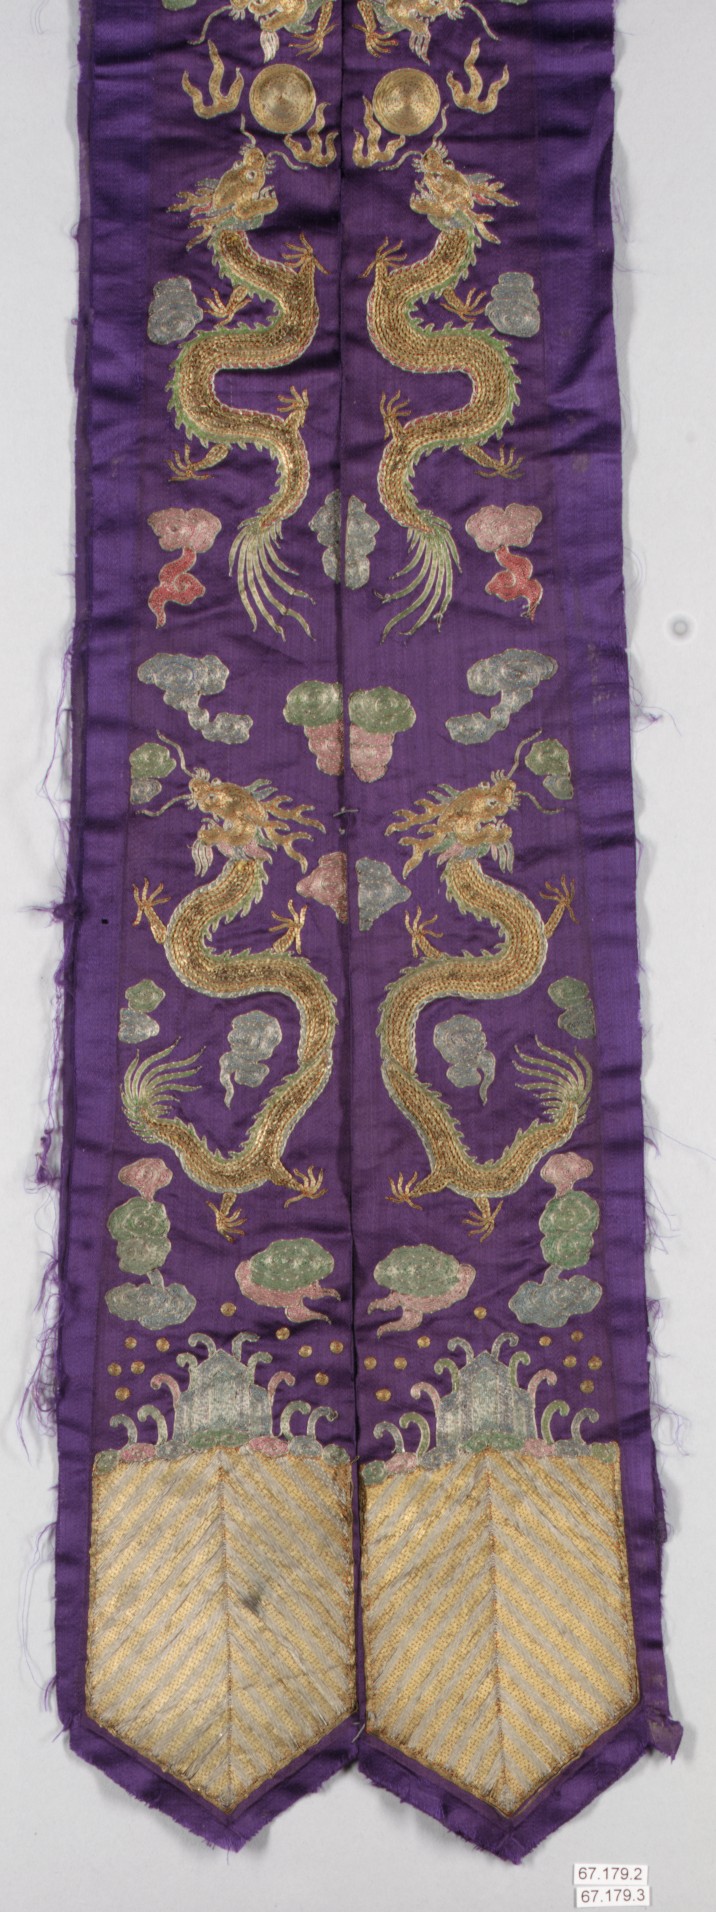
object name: streamer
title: Streamers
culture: chinese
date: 1801-1900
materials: metal thread, silk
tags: dragons